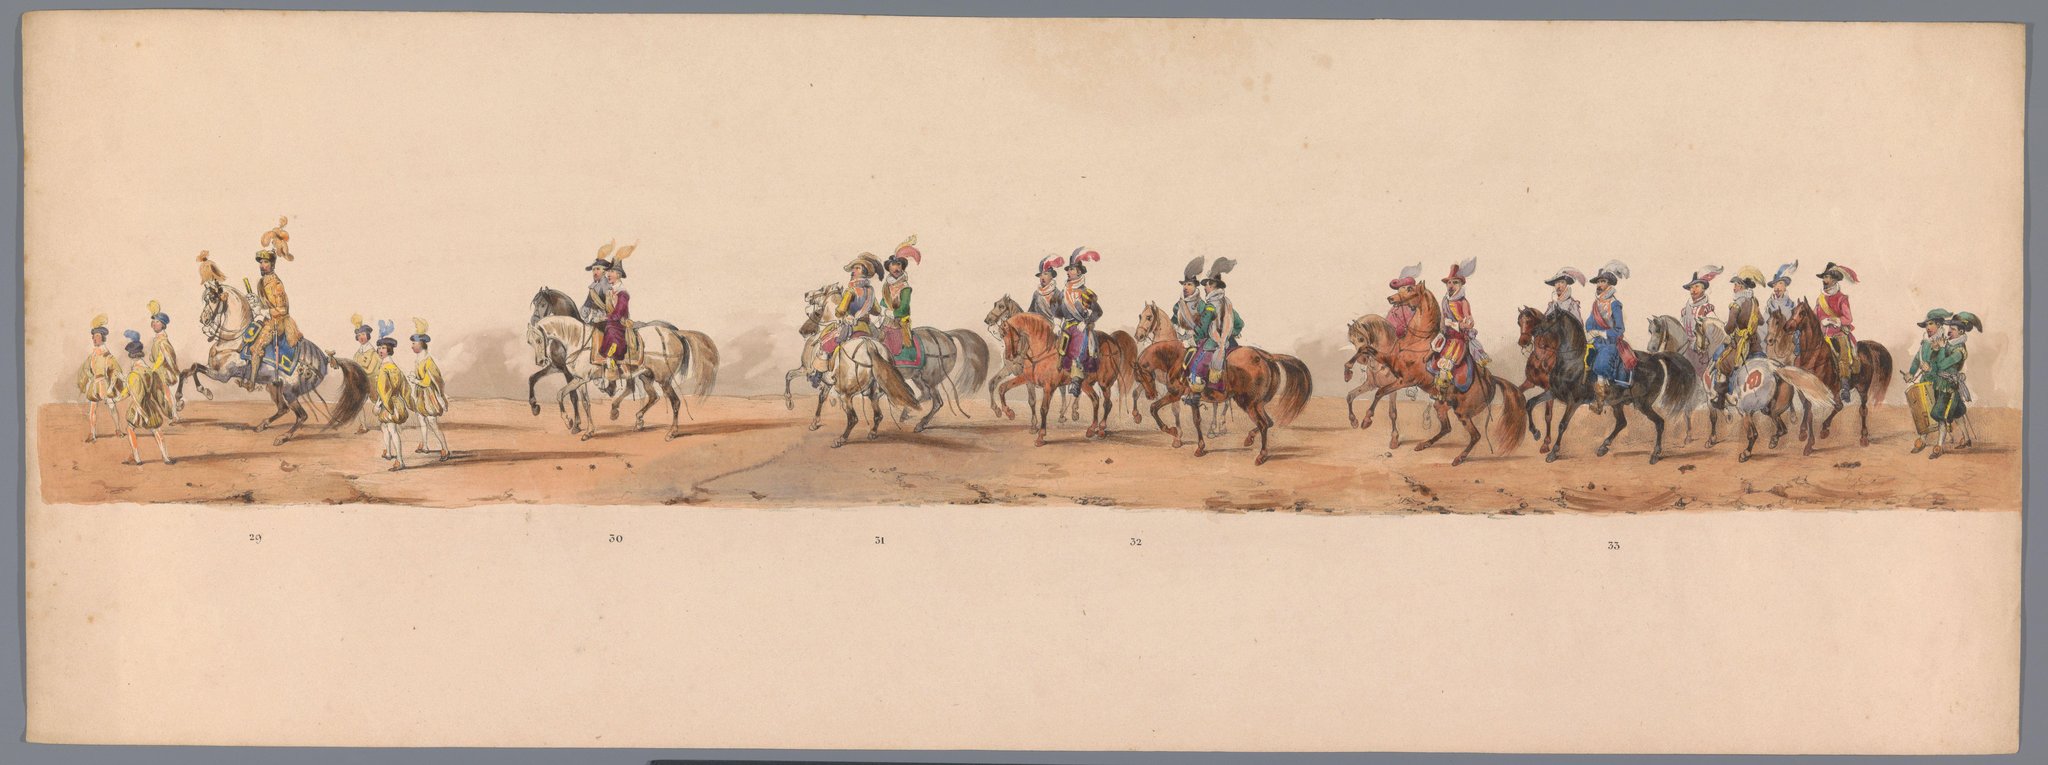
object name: print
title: Optogt des Nederlandschen Legers naar Ostende, den 3 July 1600, daags na de overwinning by Nieuwpoort; volgens de gecostumeerde voorstelling, gegeven door H H Studenten, by gelegenheid van het Tweede Eeuwfeest der Utrechtsche Hoogeschool. den 16 Juny 1836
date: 1837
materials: paper, watercolor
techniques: hand coloring, lithograph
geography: rotterdam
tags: students' pageant, costumes used in pageants, battle of nieuwpoort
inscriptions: date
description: Historische gekostumeerde optocht van de studenten van de Hogeschool van Utrecht op 16 juni 1836, bij de viering van het tweede eeuwfeest van de Utrechtse Hogeschool. De optocht verbeeldt de intocht van het Staatse leger in Oostende op 3 juli 1600, daags na de overwinning in de Slag bij Nieuwpoort. Achtste plaat in een serie van tien ongenummerde platen, met de groepen genummerd 29-33.